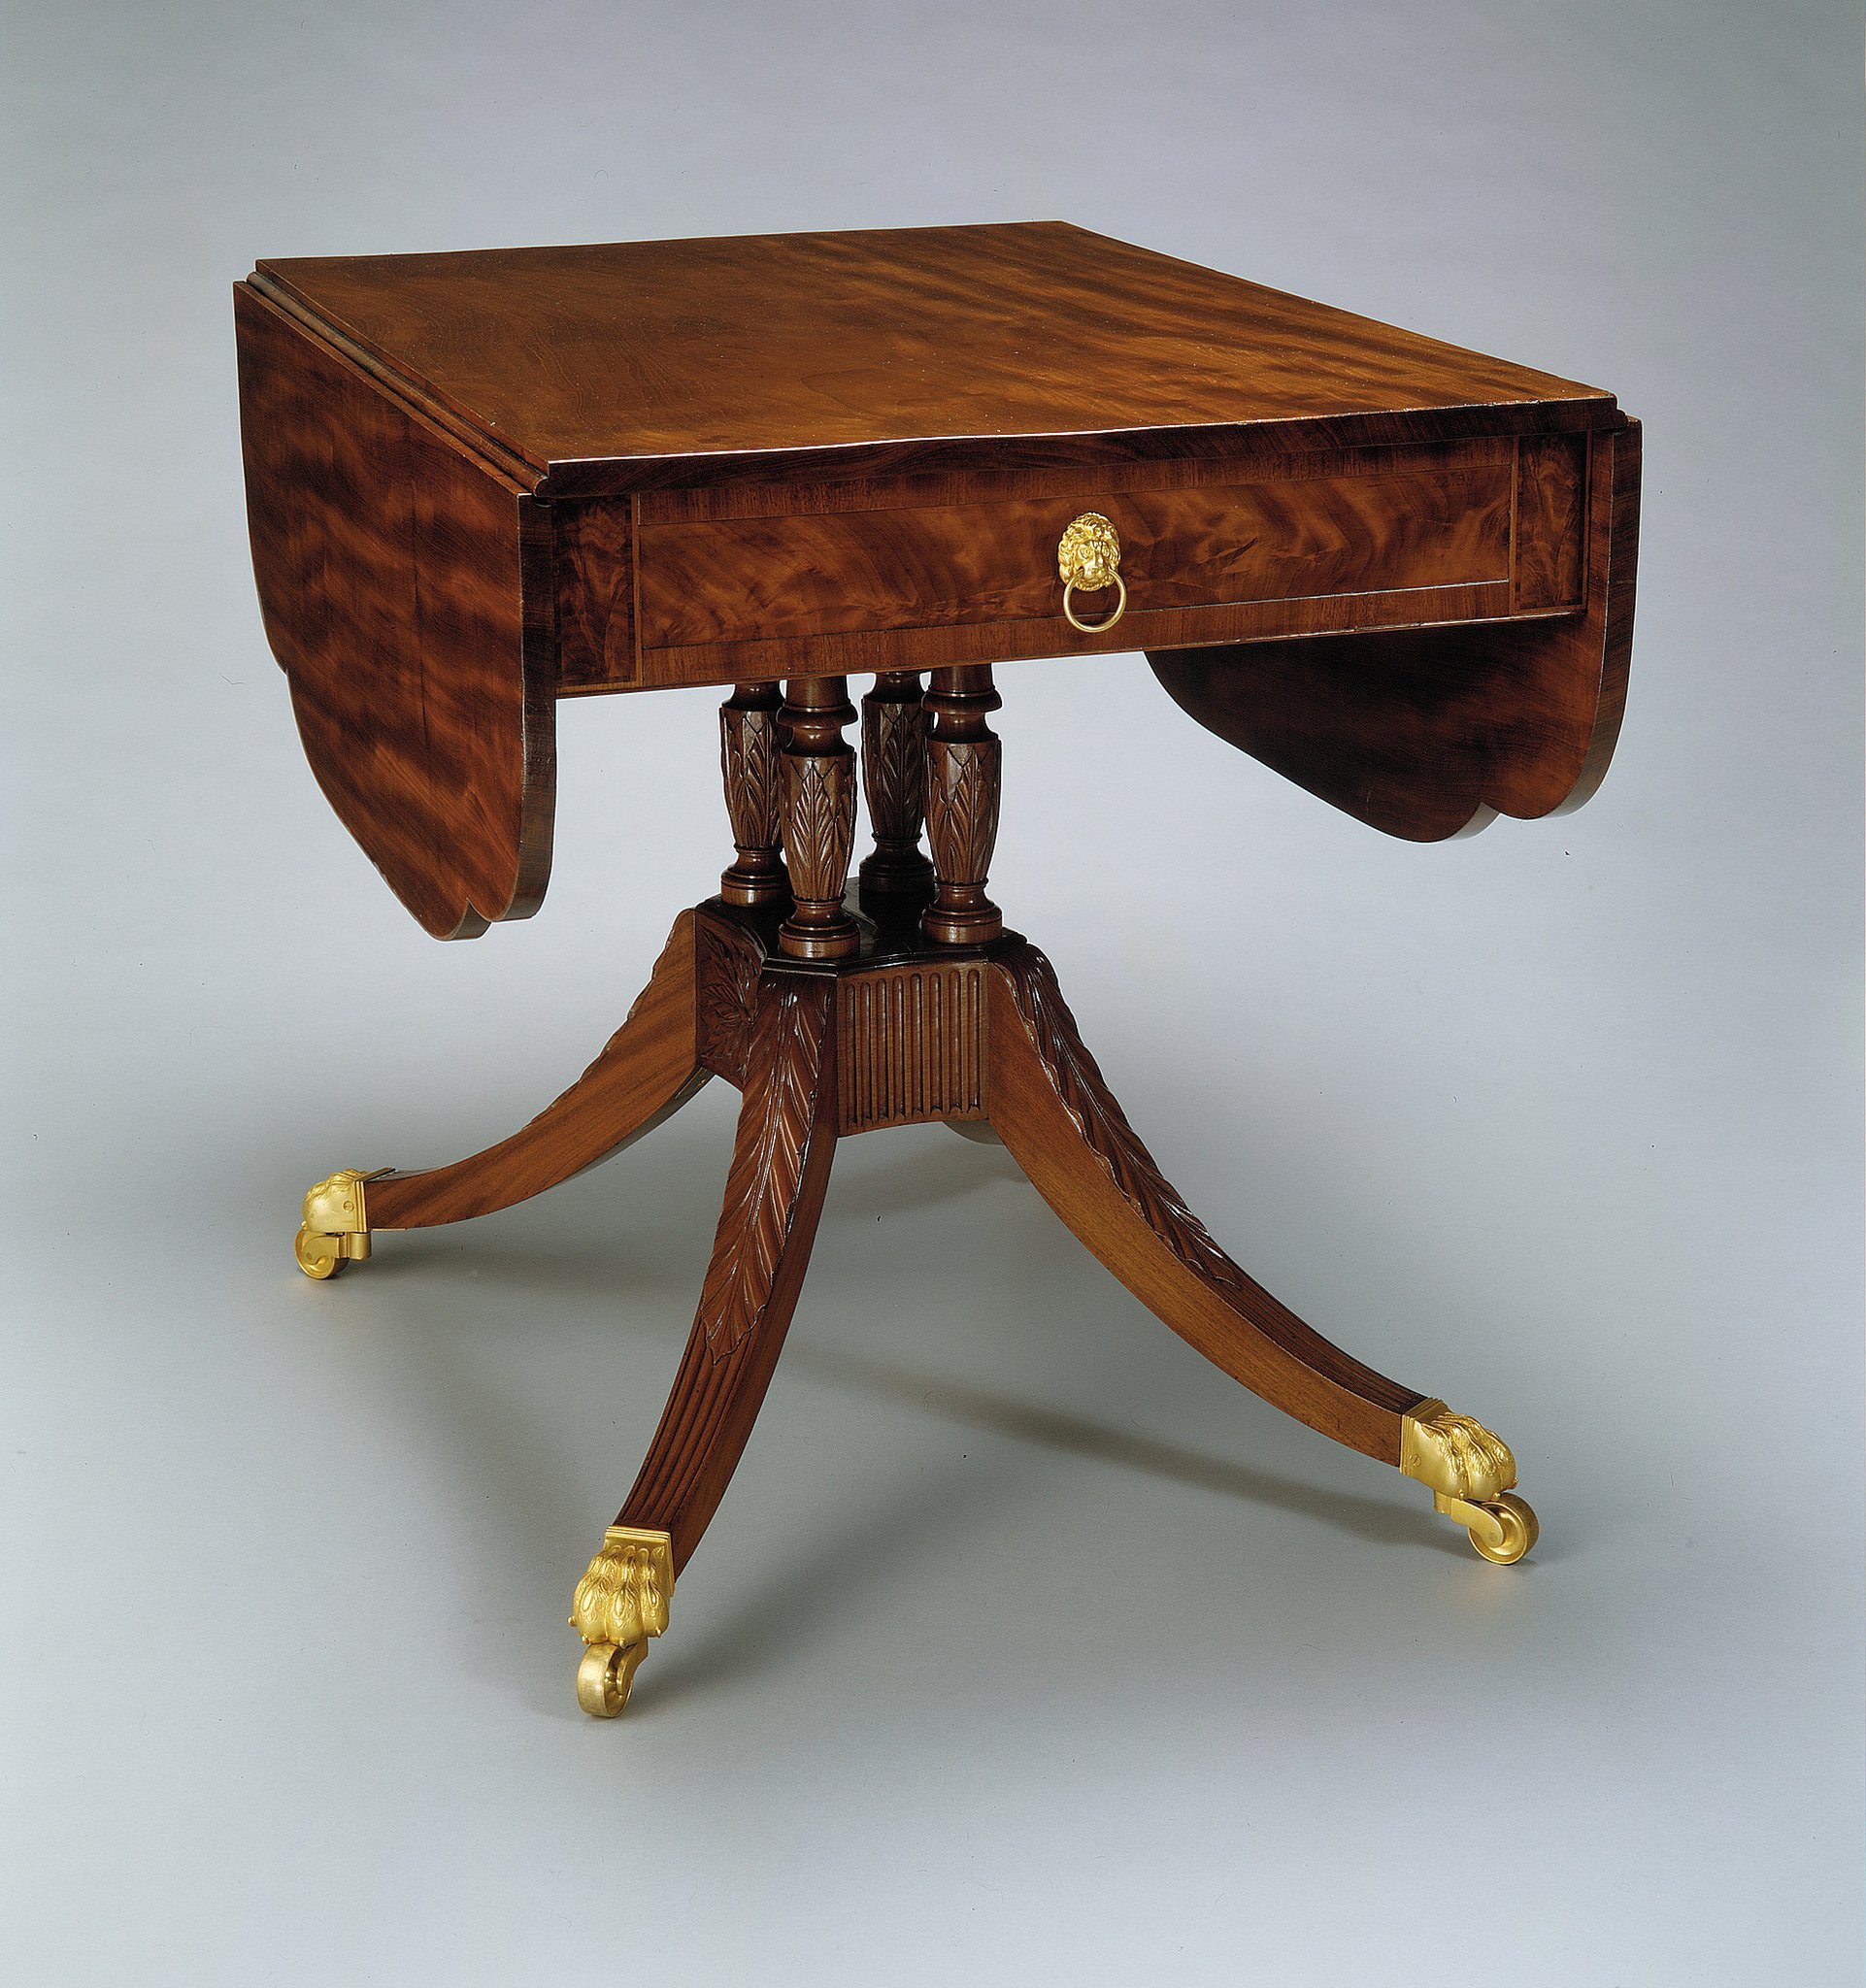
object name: drop leaf pembroke table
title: Drop-leaf Pembroke Table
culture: american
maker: duncan phyfe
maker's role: maker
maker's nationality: american, born scotland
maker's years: 1770-1854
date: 1810-1820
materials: wood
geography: united states